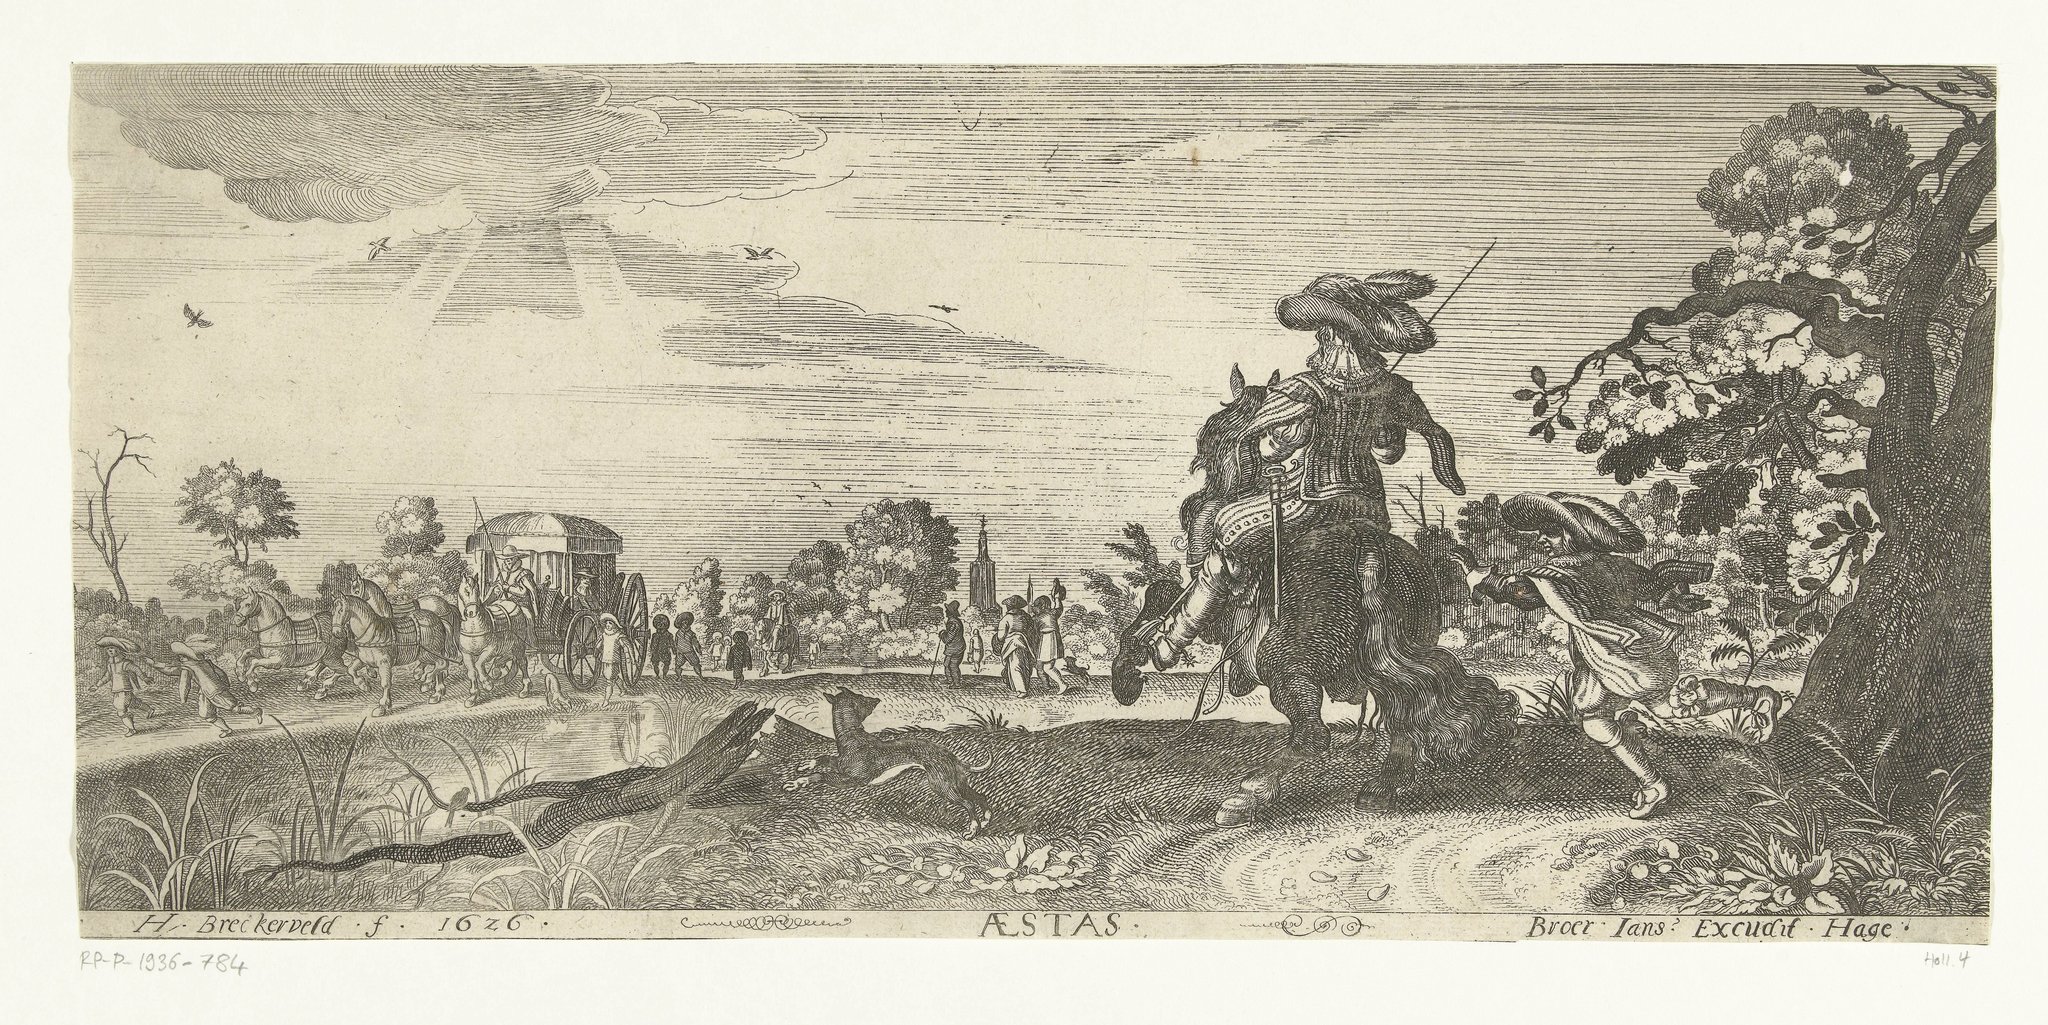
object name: print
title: De vier seizoenen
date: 1626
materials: paper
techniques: engraving, etching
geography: the hague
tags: summer ~ human activities (the four seasons of the year)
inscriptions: collector's mark: Lugt 2228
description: Landschap met rechtsvoor een ruiter met zijn hond en een, achter hem aan lopende, bediende. Aan de overkant van een vaart een koets en een wandelend gezelschap. In de verte is een kerktorenspits te zien. Voorstelling van de zomer uit een prentserie van de vier seizoenen.